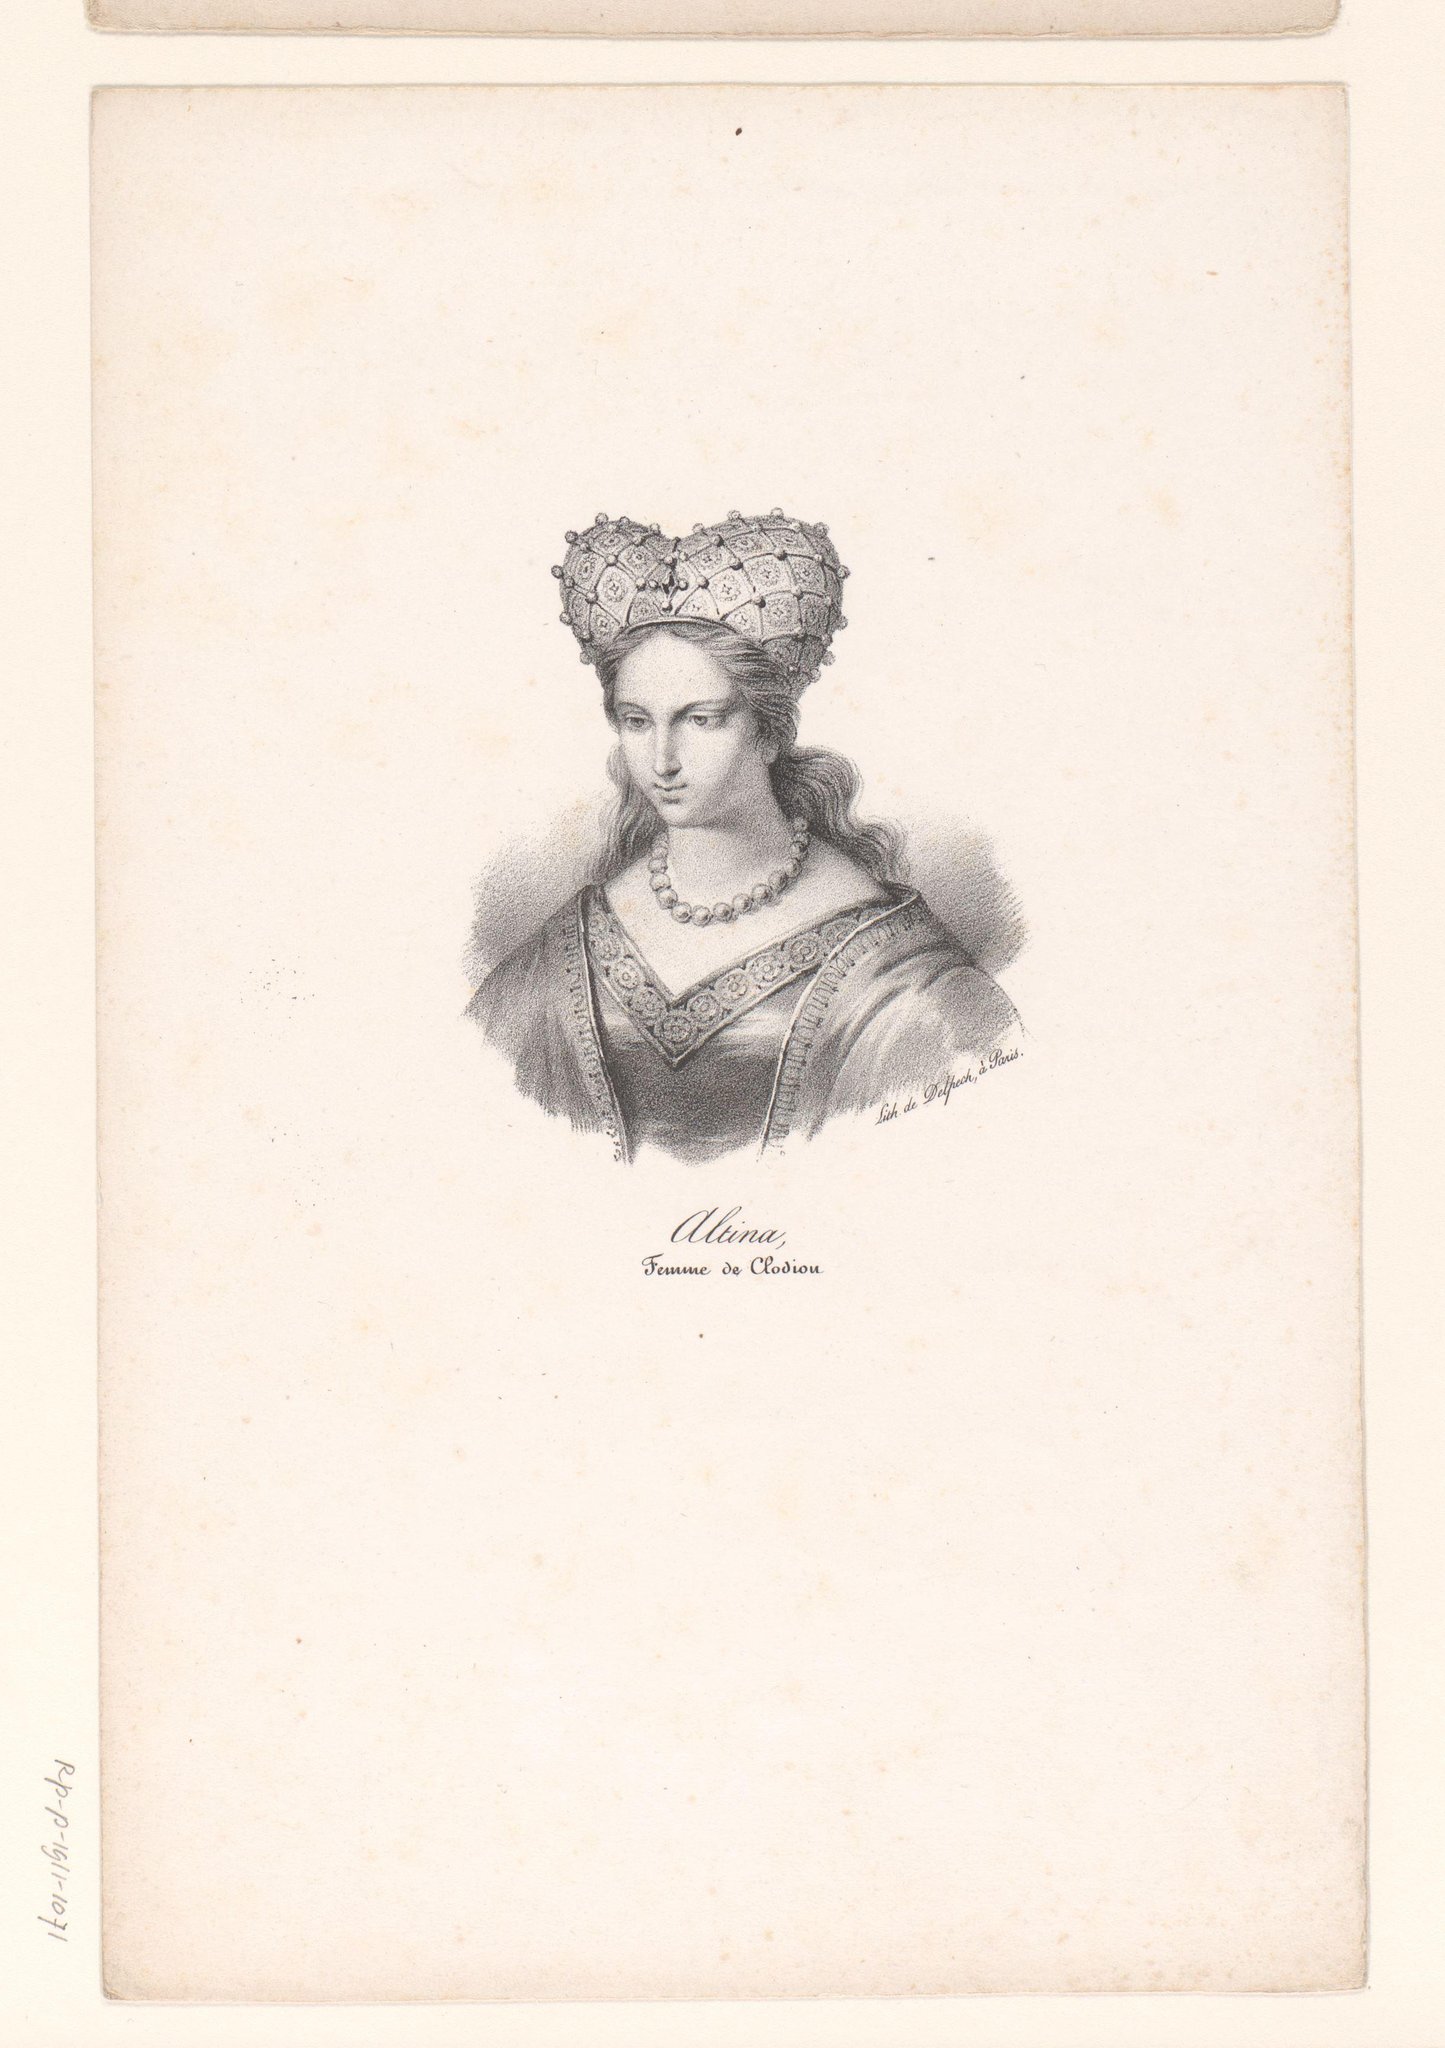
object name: print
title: Altina, femme de Clodion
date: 1818-1842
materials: paper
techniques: lithograph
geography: paris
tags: historical persons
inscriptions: collector's mark: Lugt 2228a